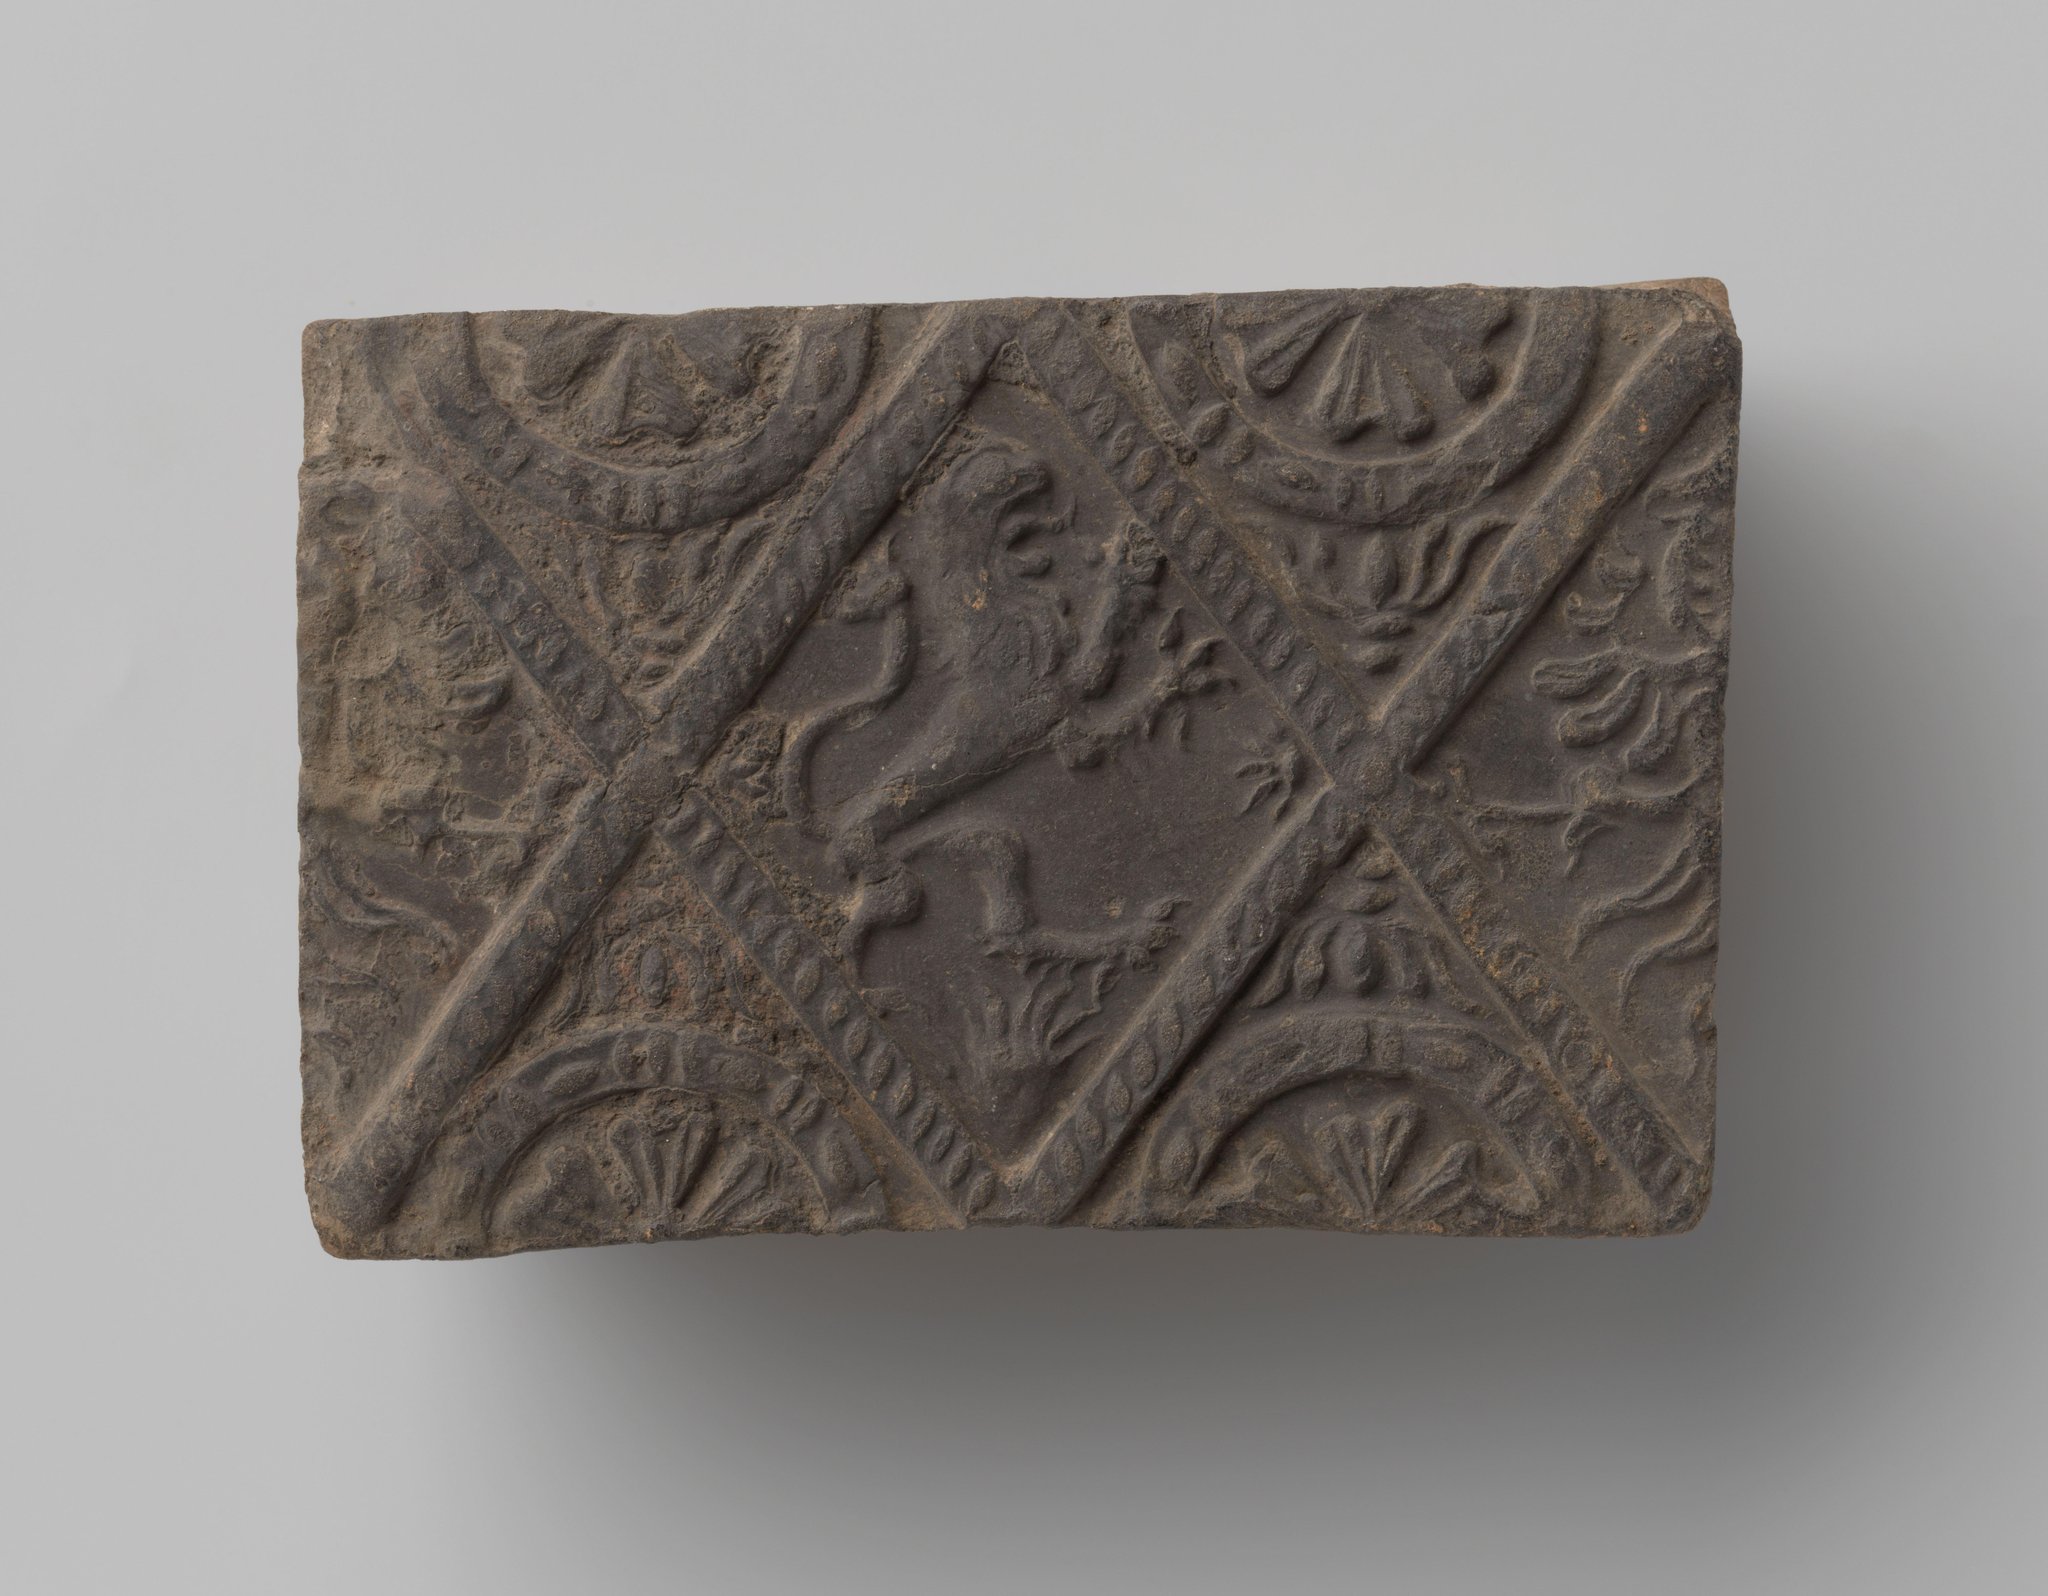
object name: hearthstone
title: Haardsteen met voorstelling van klimmende leeuw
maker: Anonymous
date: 1575-1625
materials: earthenware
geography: southern netherlands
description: Haardsteen met voorstelling van klimmende leeuw naar links (heraldisch) , geplaatst in geprofileerde ruit. In de halve ruiten aan de zijkanten een dubbelkoppige adelaar. De halve ruiten aan de boven- en onderkant zijn opgevuld met halve medaillons met stermotief.